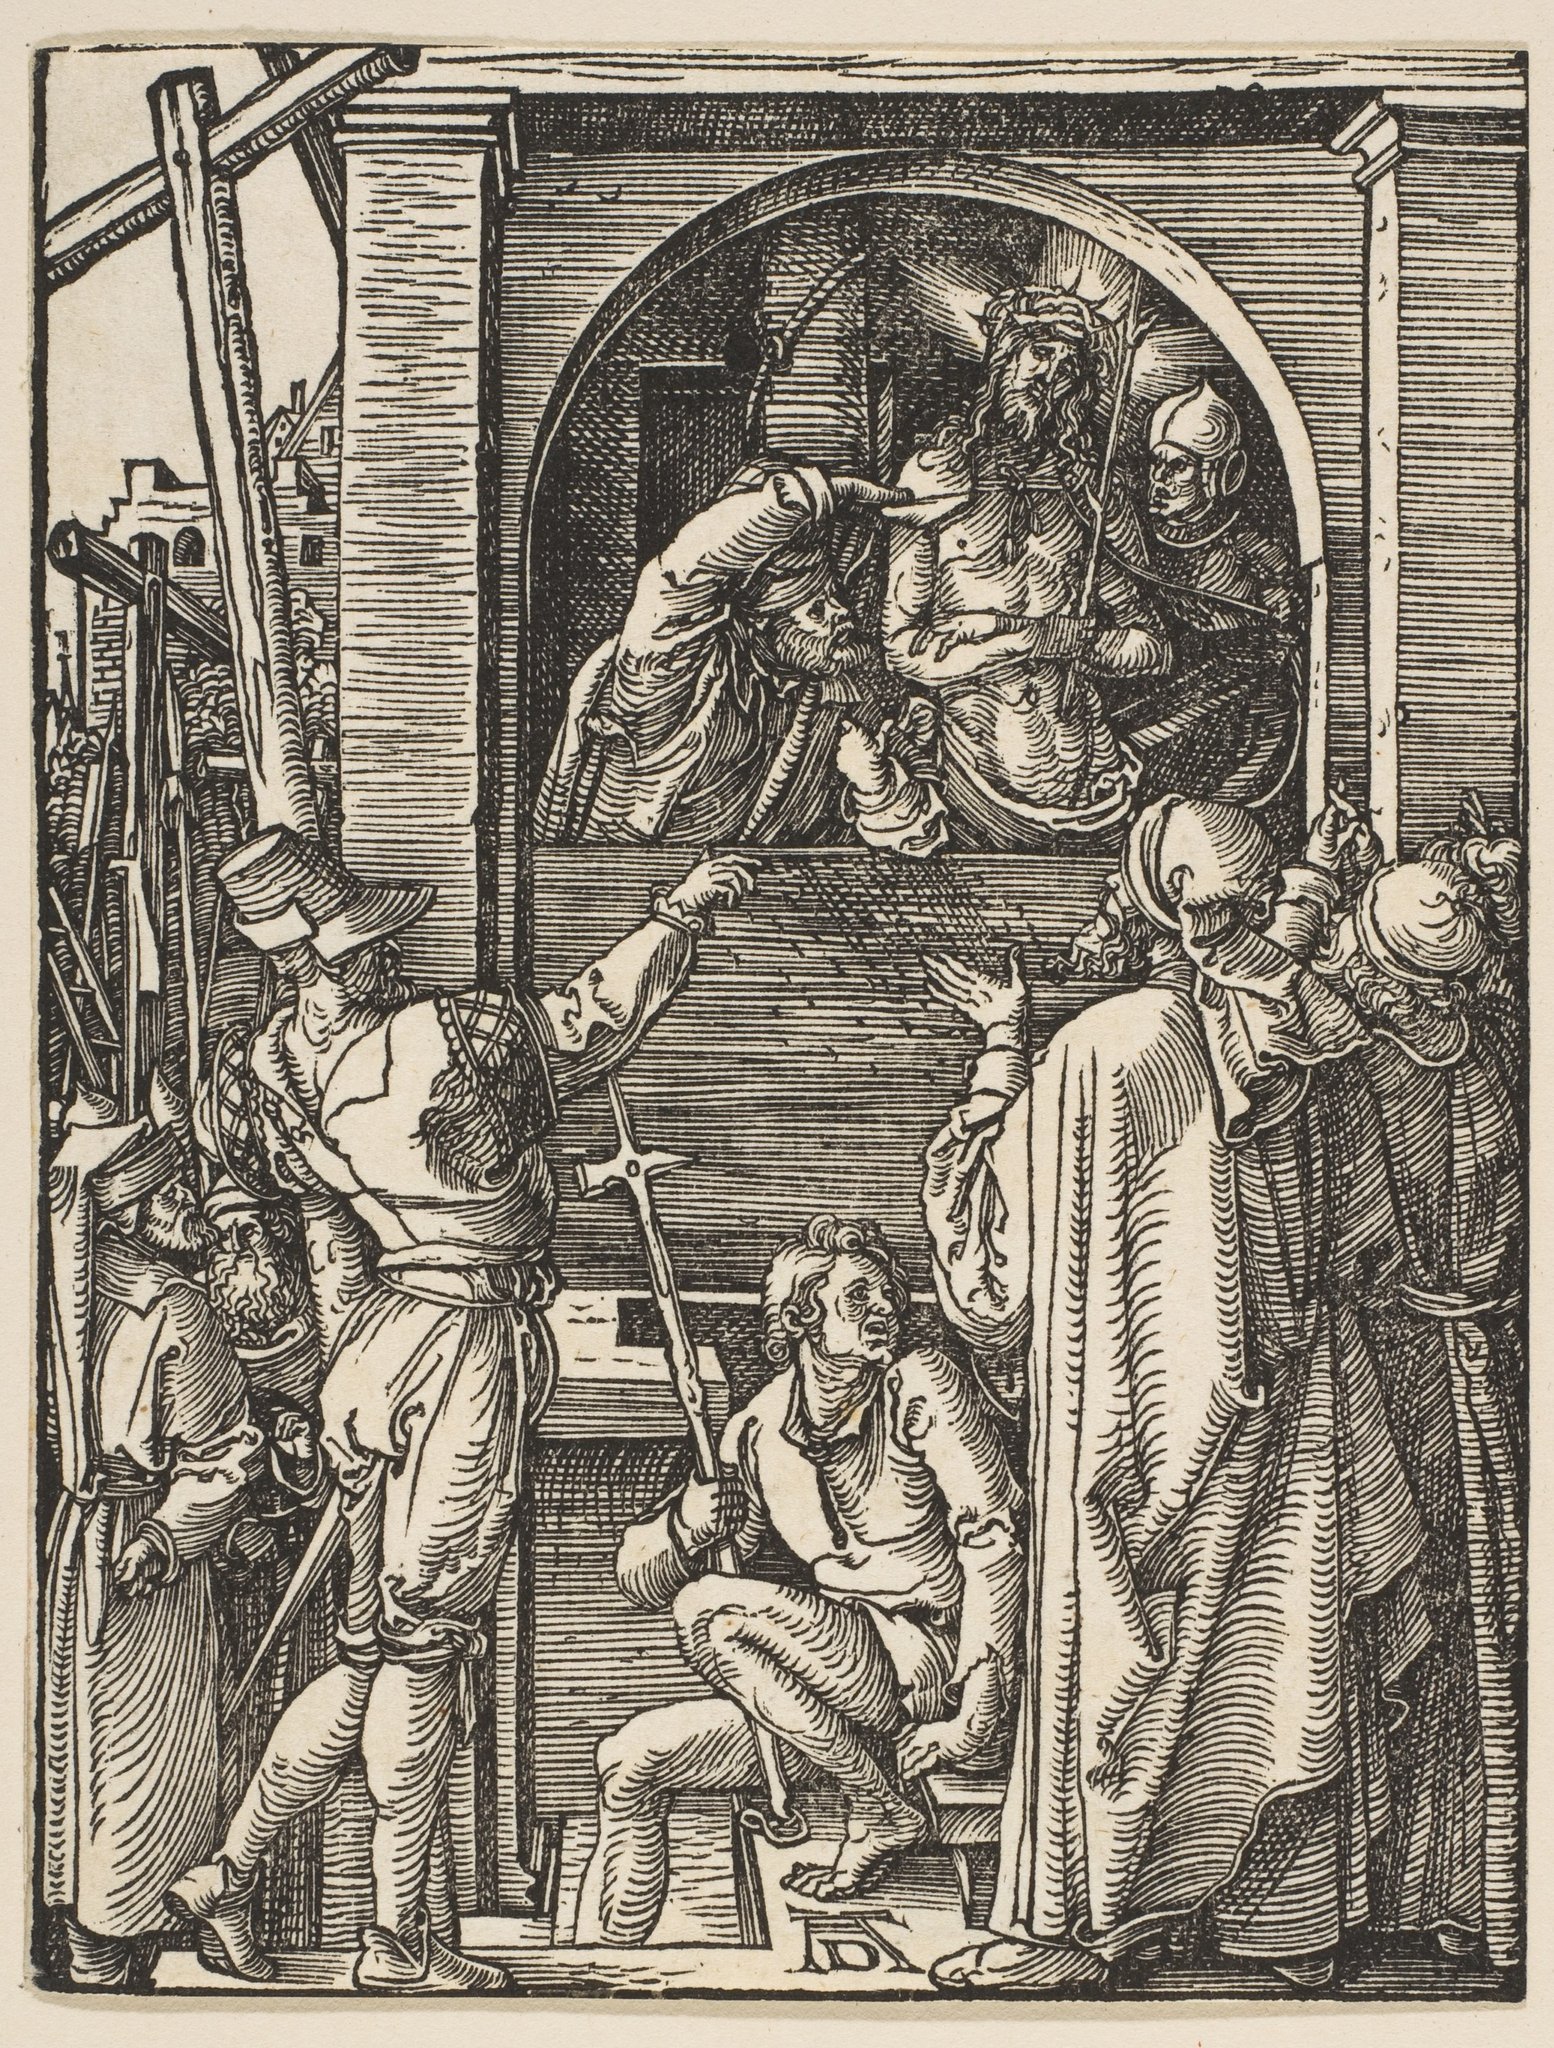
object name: print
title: Ecce Homo, from "The Small Passion"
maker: albrecht dürer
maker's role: artist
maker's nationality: german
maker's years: 1471-1528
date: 1509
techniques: woodcut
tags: soldiers,weapons,men,christ